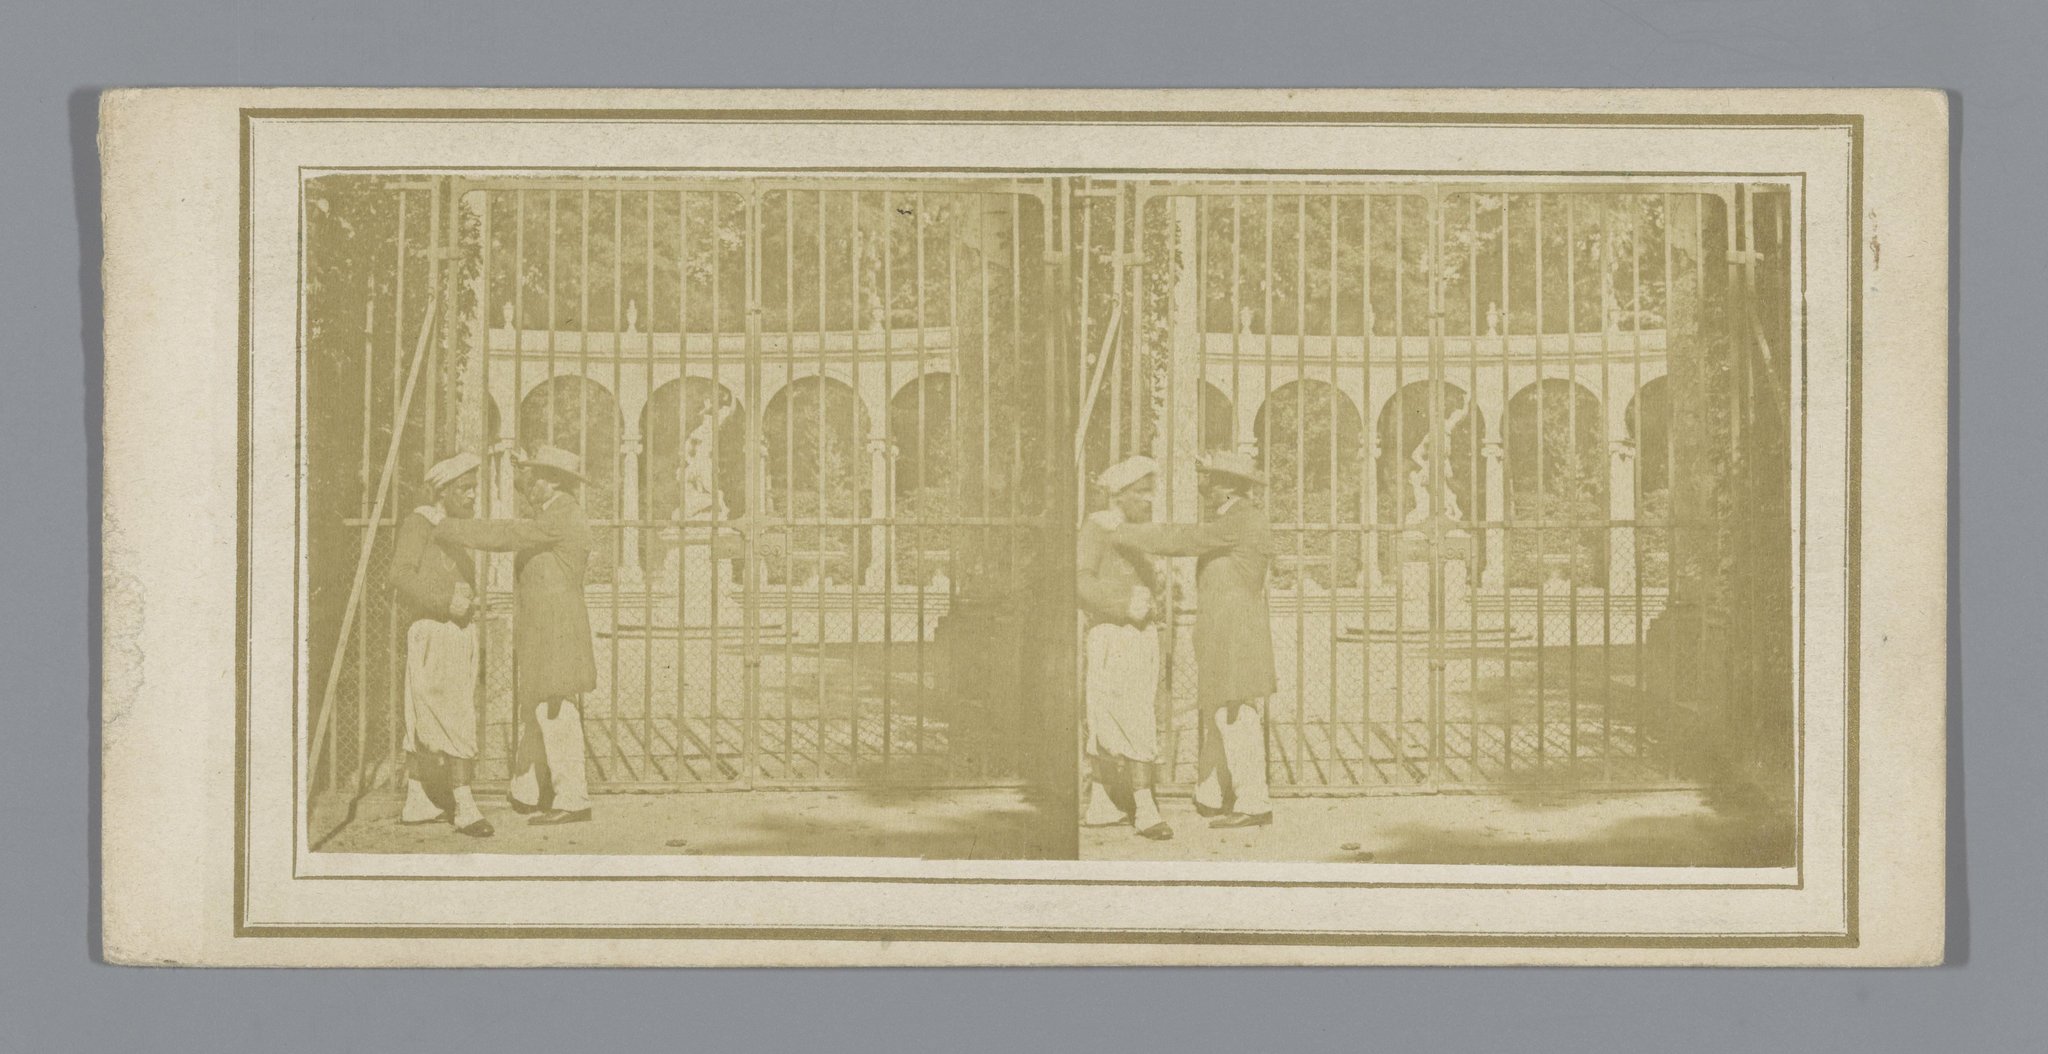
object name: stereograph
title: Twee mannen voor een hek in de Tuin van Versailles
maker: Anonymous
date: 1850-1875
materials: cardboard, photographic support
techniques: albumen print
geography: gardens of versailles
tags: fence, wall, paling, adult man, sculpture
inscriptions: number: ‘No 21’, inscription: ‘Versailles’